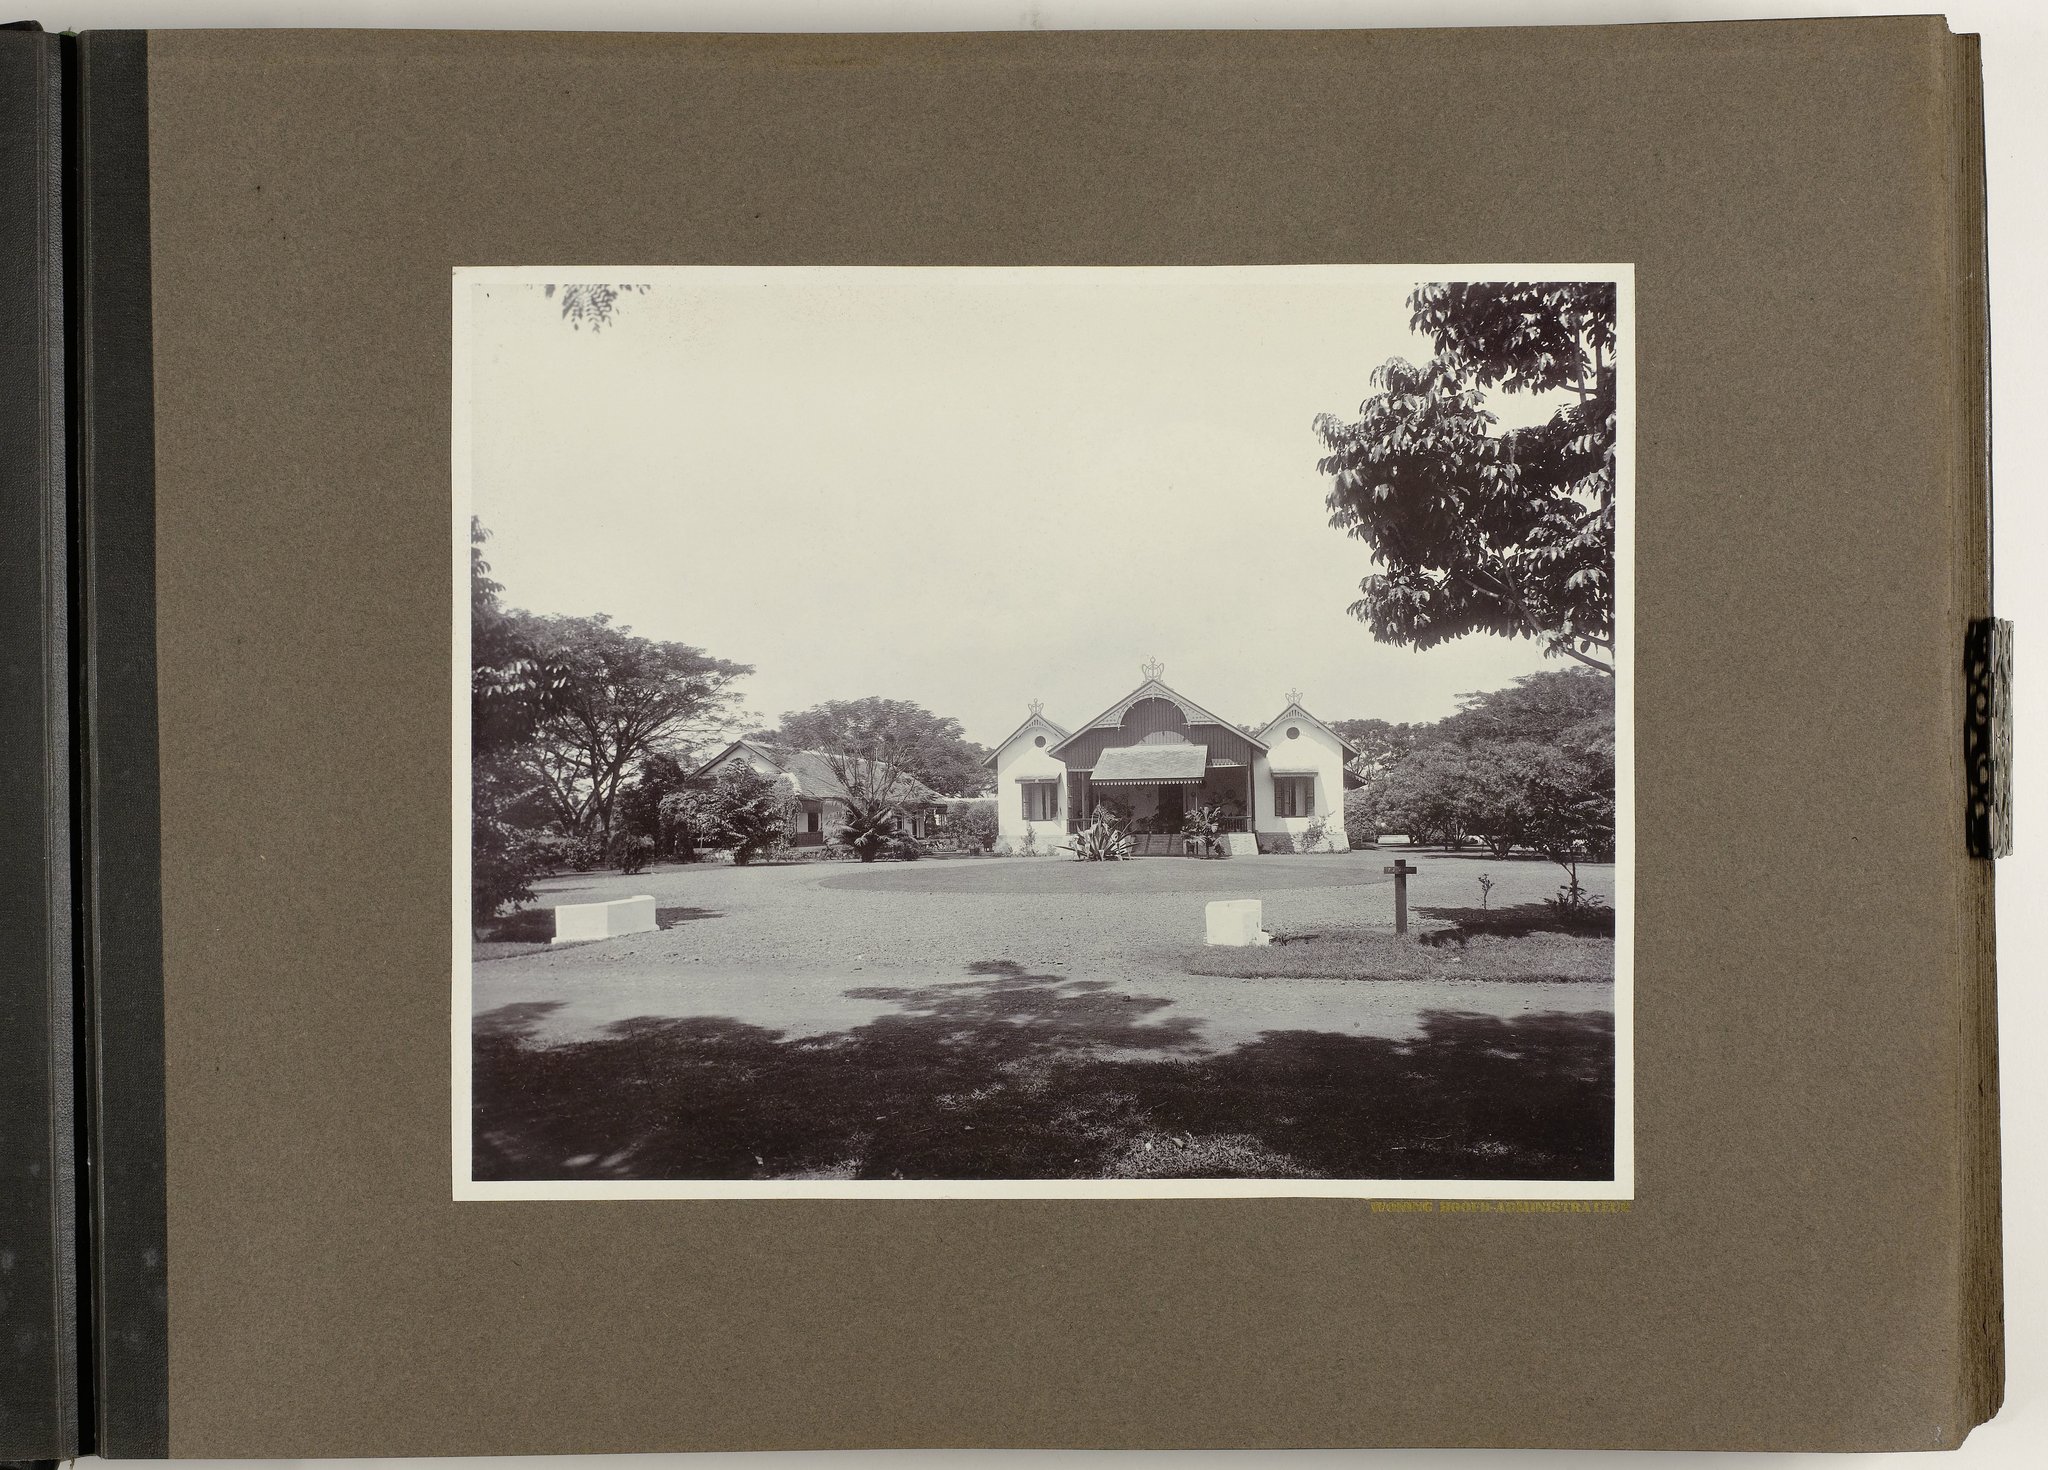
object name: photograph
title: Woning hoofd-administrateur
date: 1917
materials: photographic support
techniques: gelatin silver print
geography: jatiroto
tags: colonial system, (non-fruit) products of plants or trees: sugarcane, villa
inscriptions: inscription: ‘WONING HOOFD-ADMINISTRATEUR’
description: Vrijstaand huis omgeven door gazon en bomen. Daarvoor een ronde oprijlaan met een kruisvormig naambordje 'F. J. Wirix'. Onderdeel van het fotoalbum aangeboden aan F.J. Wirix door het personeel van de Suikeronderneming Djatiroto in 1917.